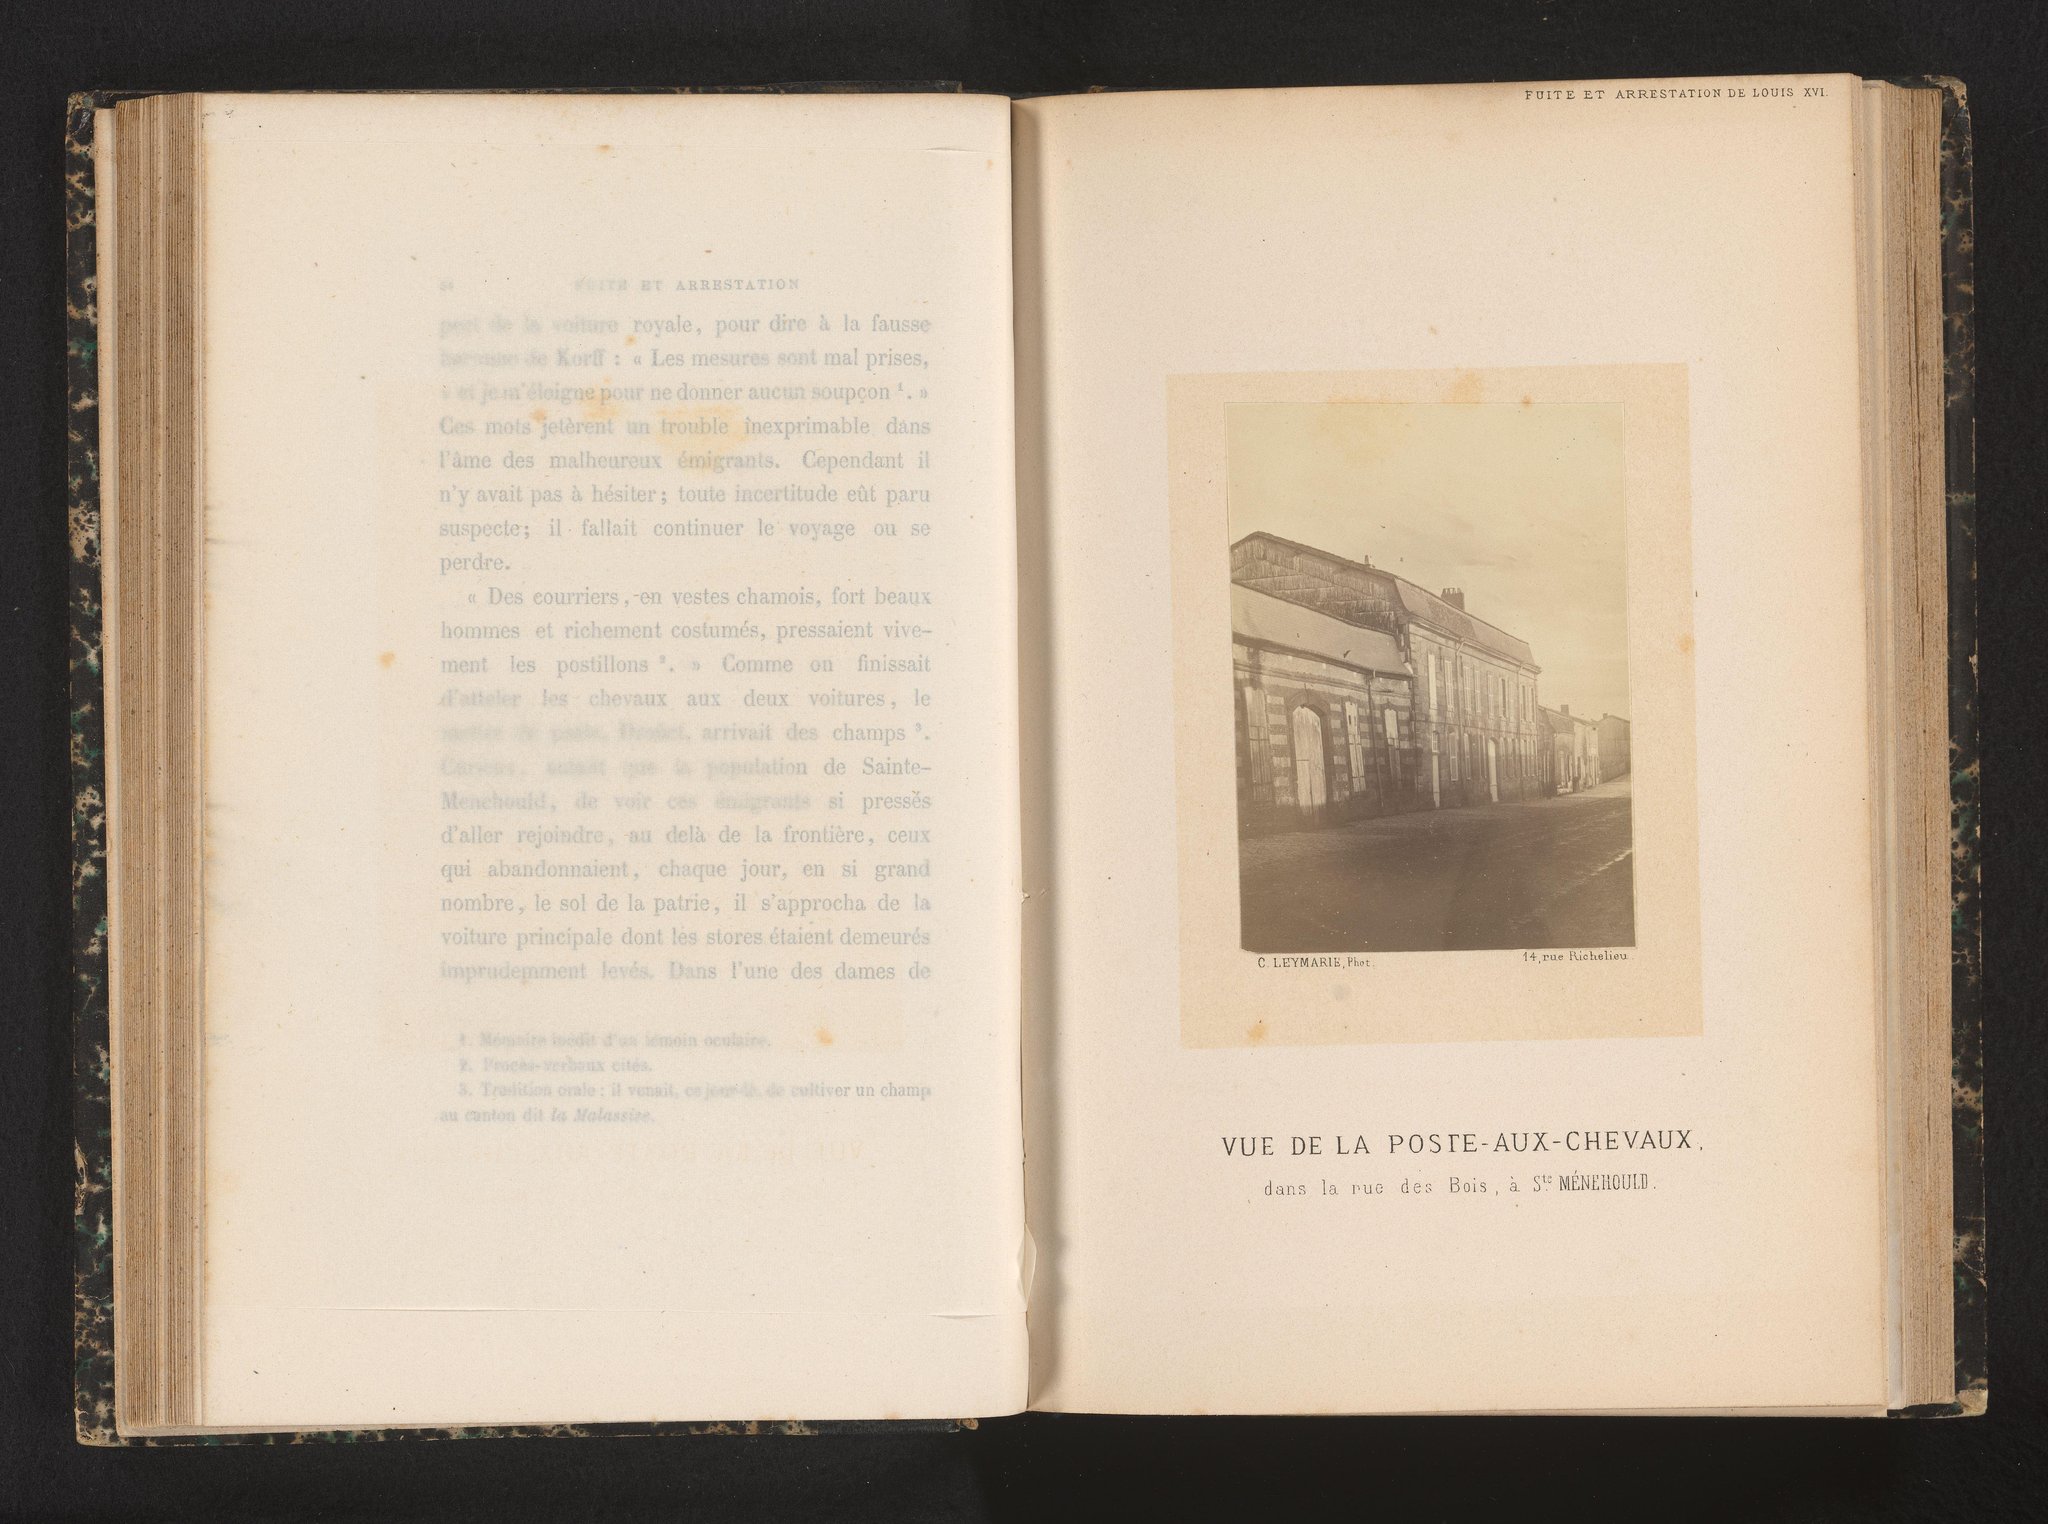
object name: page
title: Vue de la Poste-aux-Chevaux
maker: charles leymarie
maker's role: fotograaf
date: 1856-1866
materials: paper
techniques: albumen print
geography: sainte-menehould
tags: post-office, stall, stable, street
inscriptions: inscription: ‘dans la rue des Bois, à Ste Ménehould’, address: ‘14, rue Richelieu’